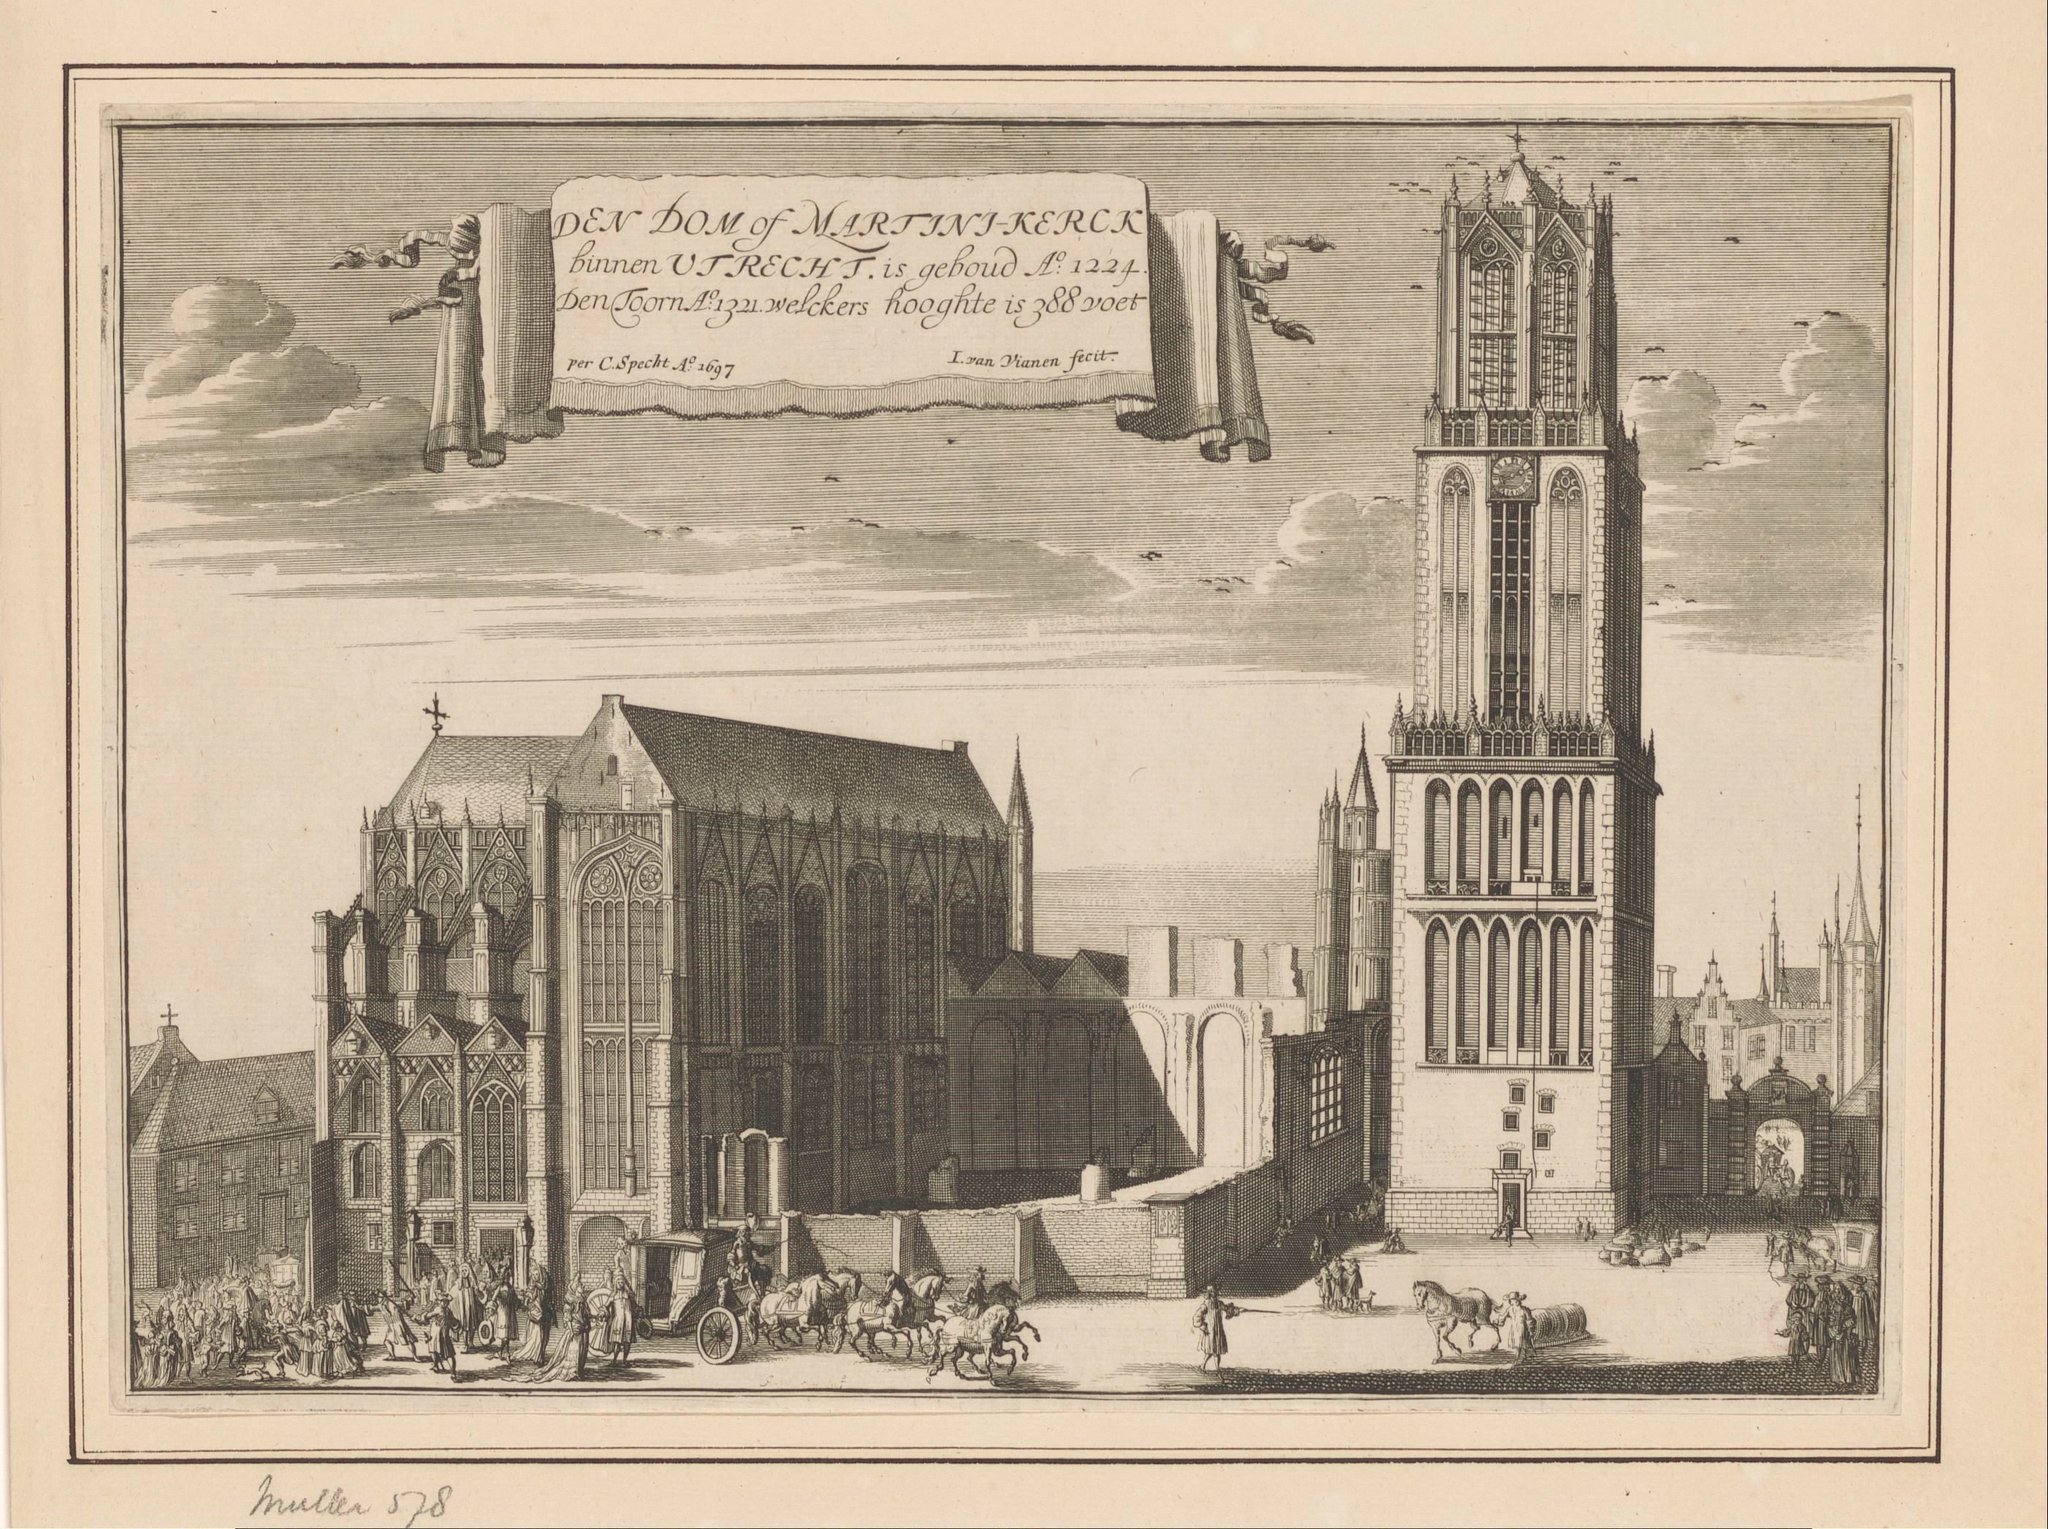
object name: print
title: Gezicht op de Dom in Utrecht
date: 1697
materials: paper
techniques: engraving, etching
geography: utrecht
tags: parts of church exterior and annexes: dome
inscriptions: collector's mark: Lugt 195